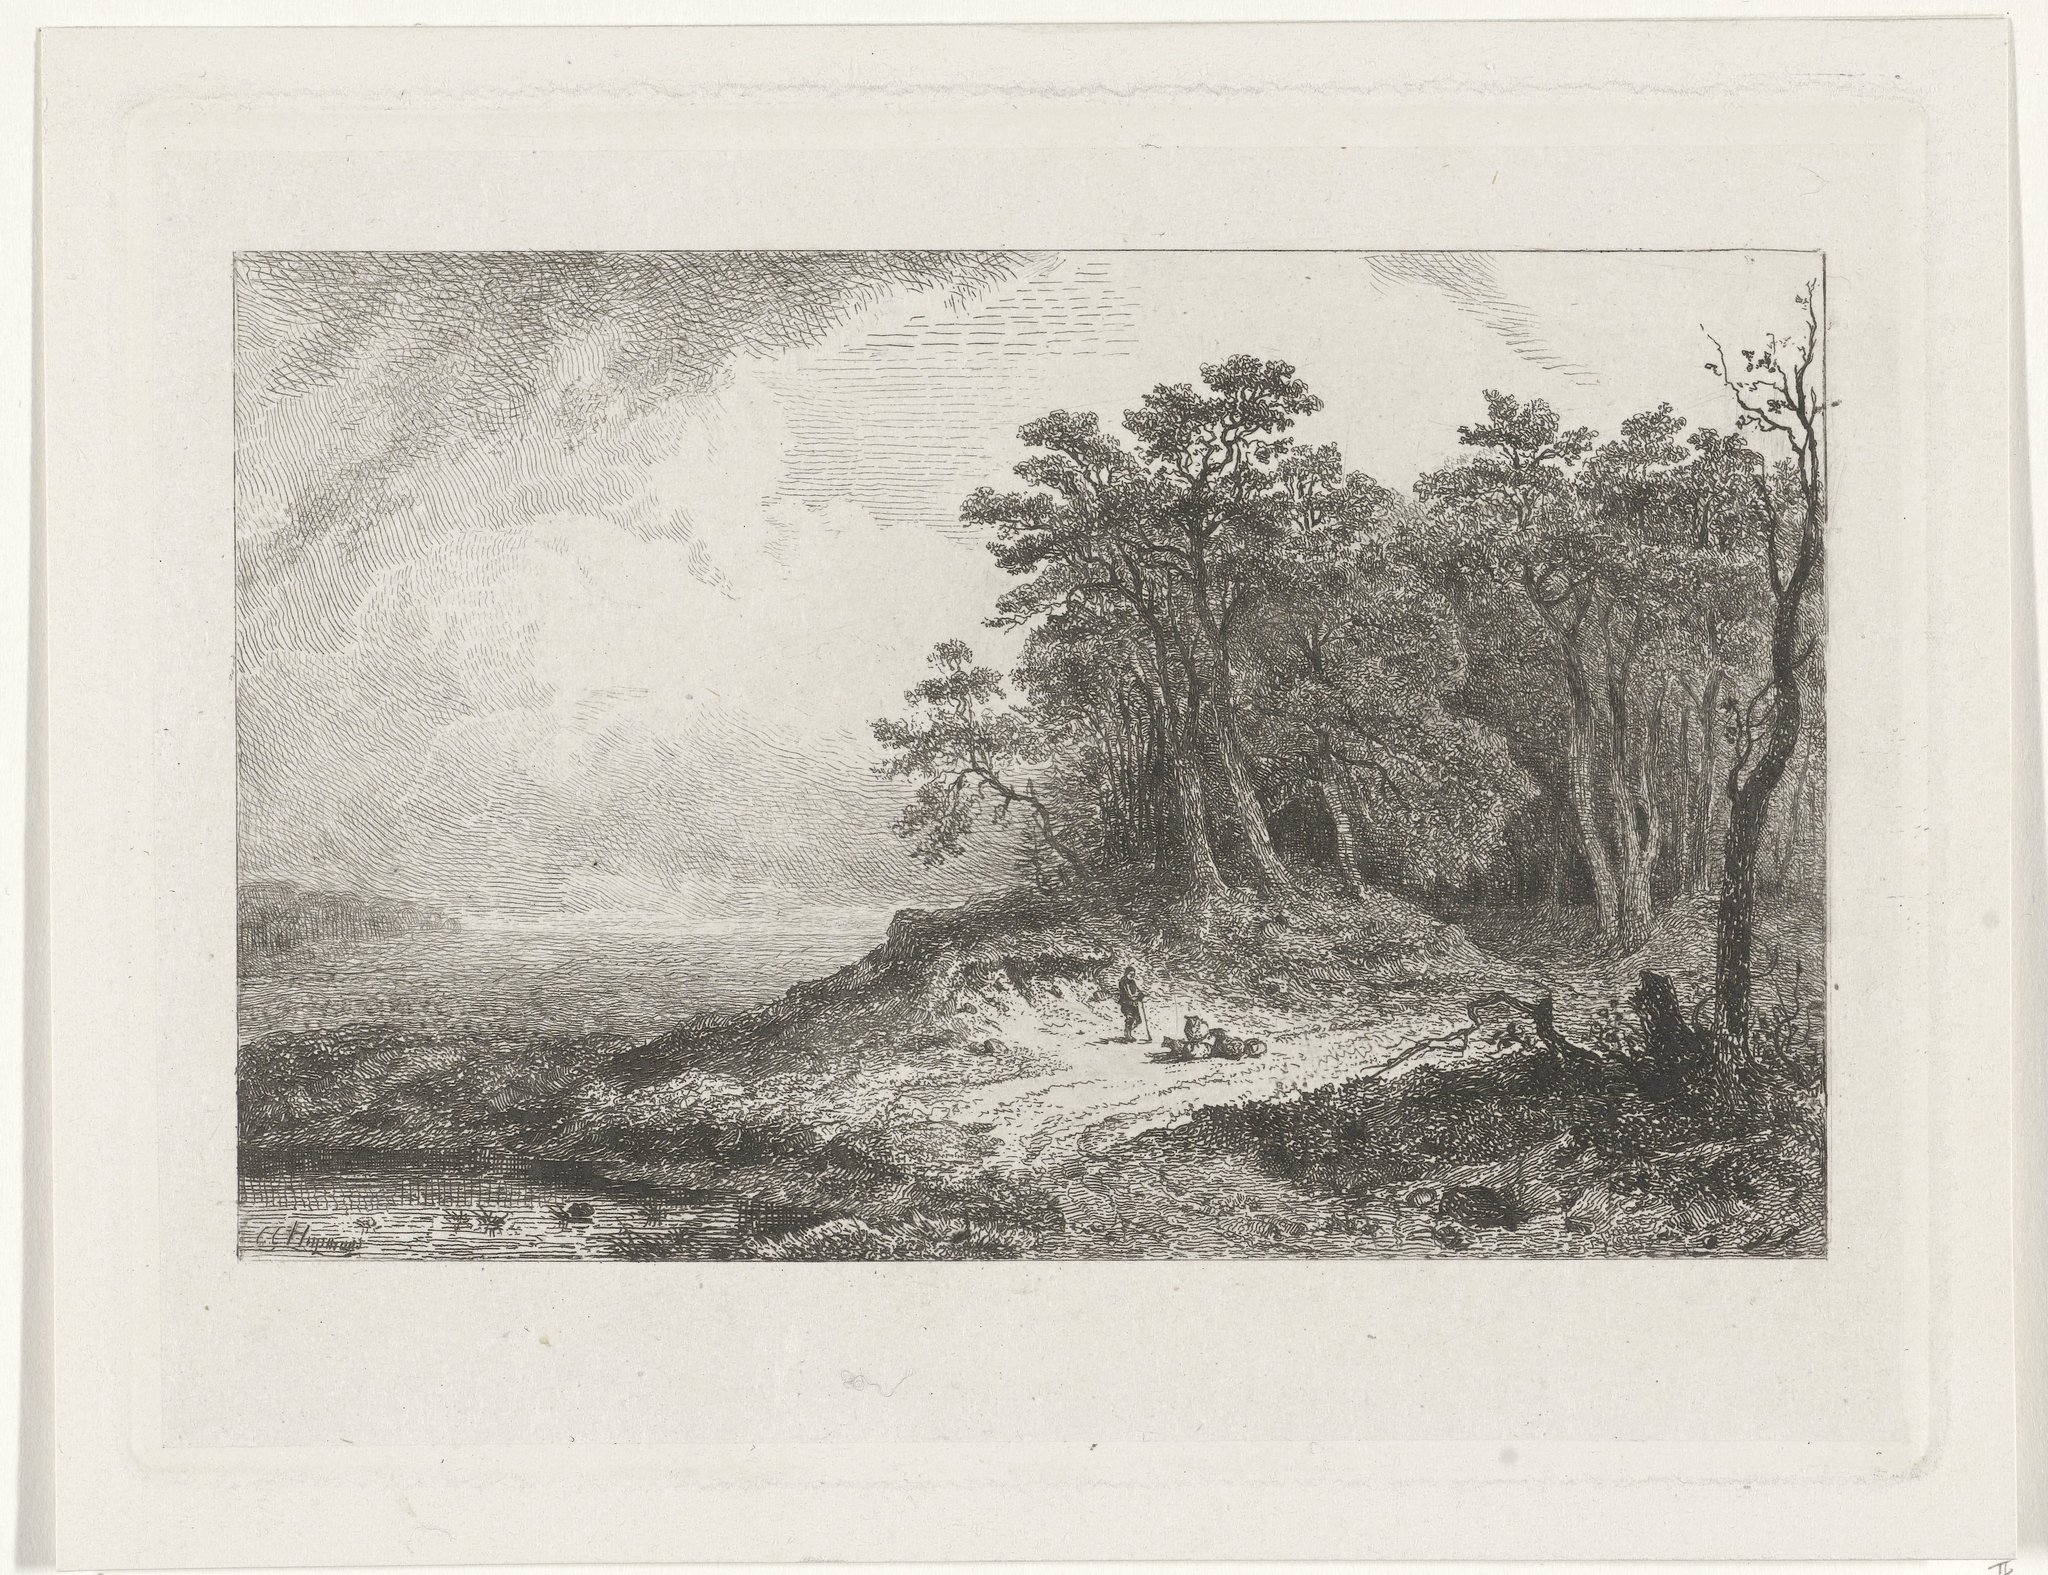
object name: print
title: Landschap met herder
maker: constantinus cornelis huysmans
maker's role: draughtsman, print maker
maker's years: 1810-1886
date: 1820-1886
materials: paper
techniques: engraving, etching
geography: breda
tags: herding, herdsman, herdswoman, shepherd, shepherdess, cowherd, etc., forest, wood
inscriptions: collector's mark: Lugt 2228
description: Bosrijk landschap met een herder met staf en schapen. Links een meertje.